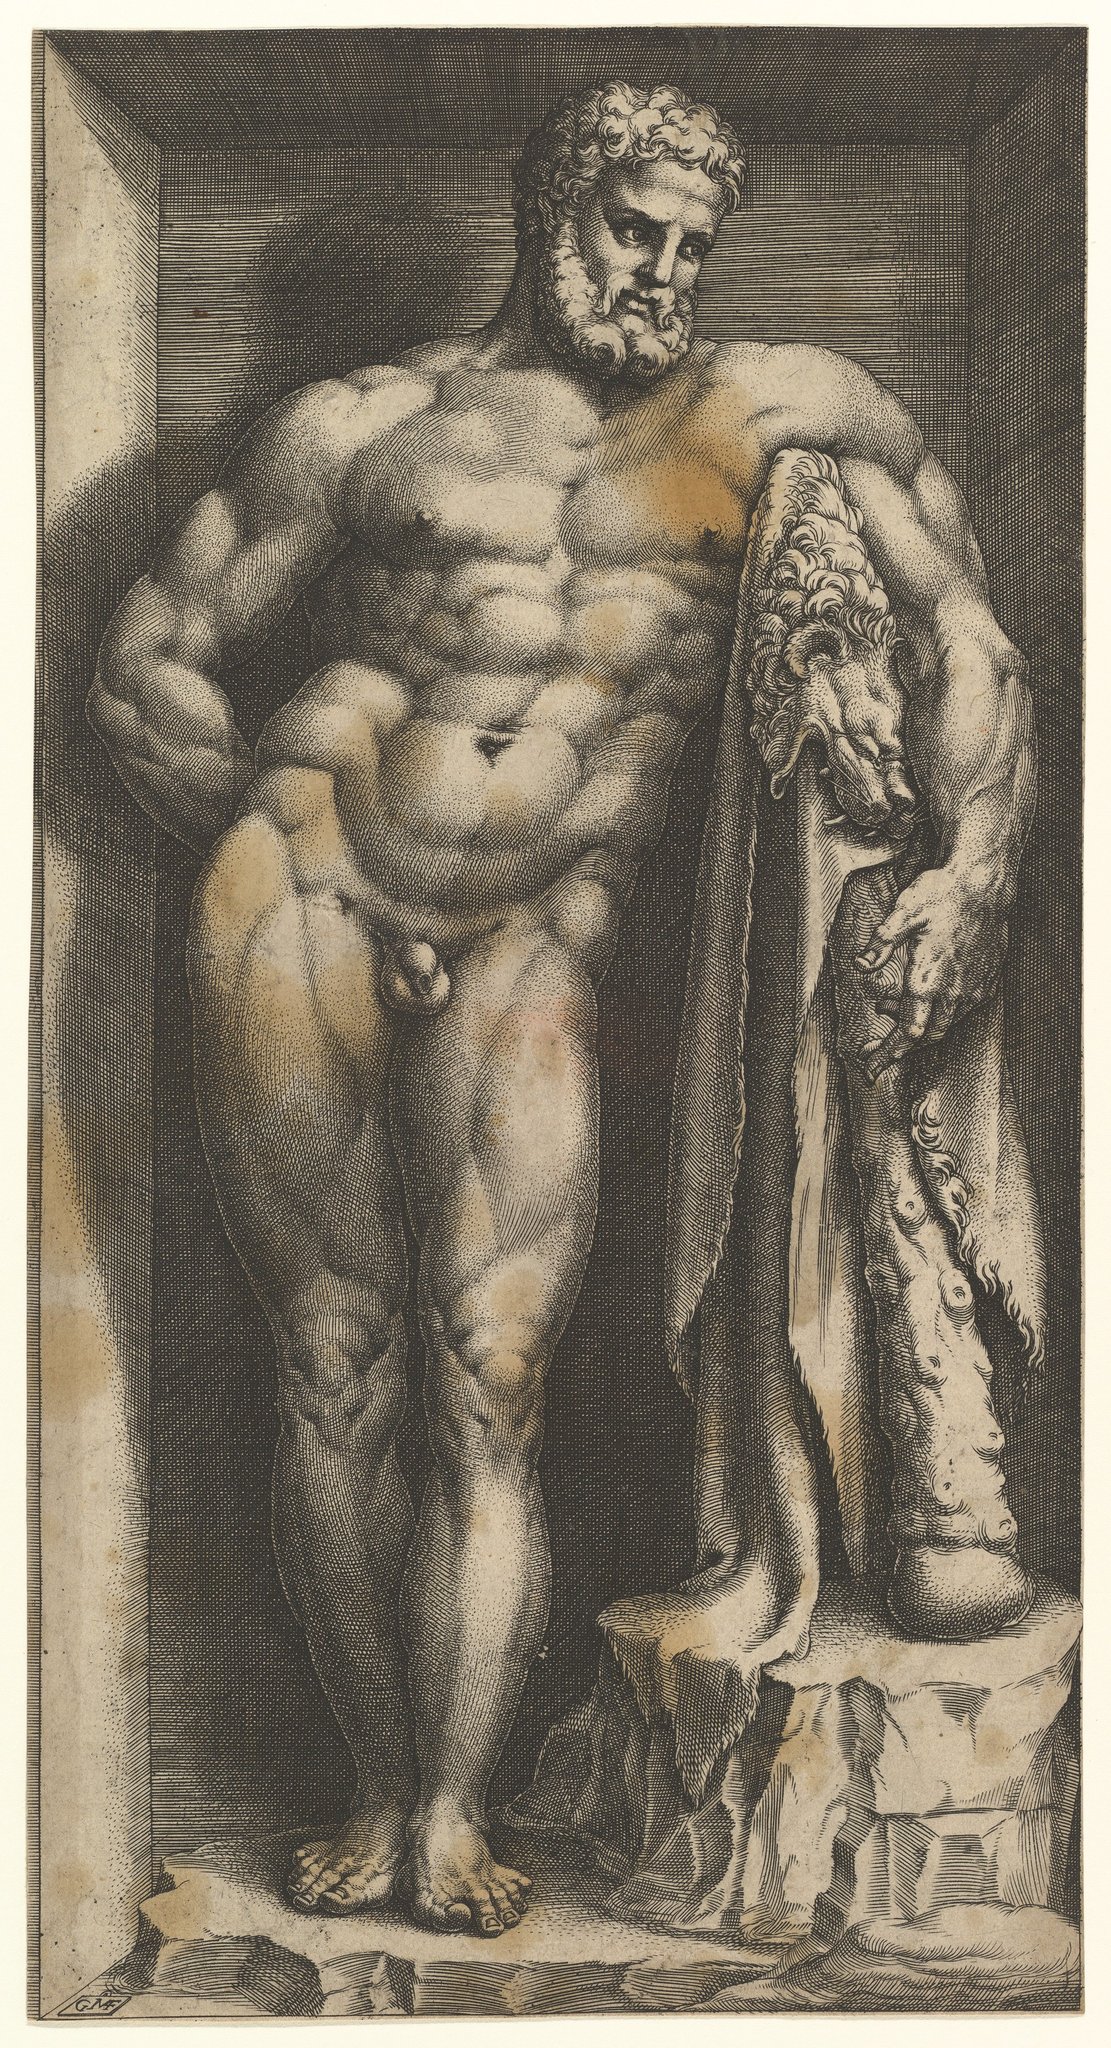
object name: print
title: The Farnese Hercules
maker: giorgio ghisi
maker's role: artist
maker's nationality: italian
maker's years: 1515-1582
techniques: engraving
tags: hercules